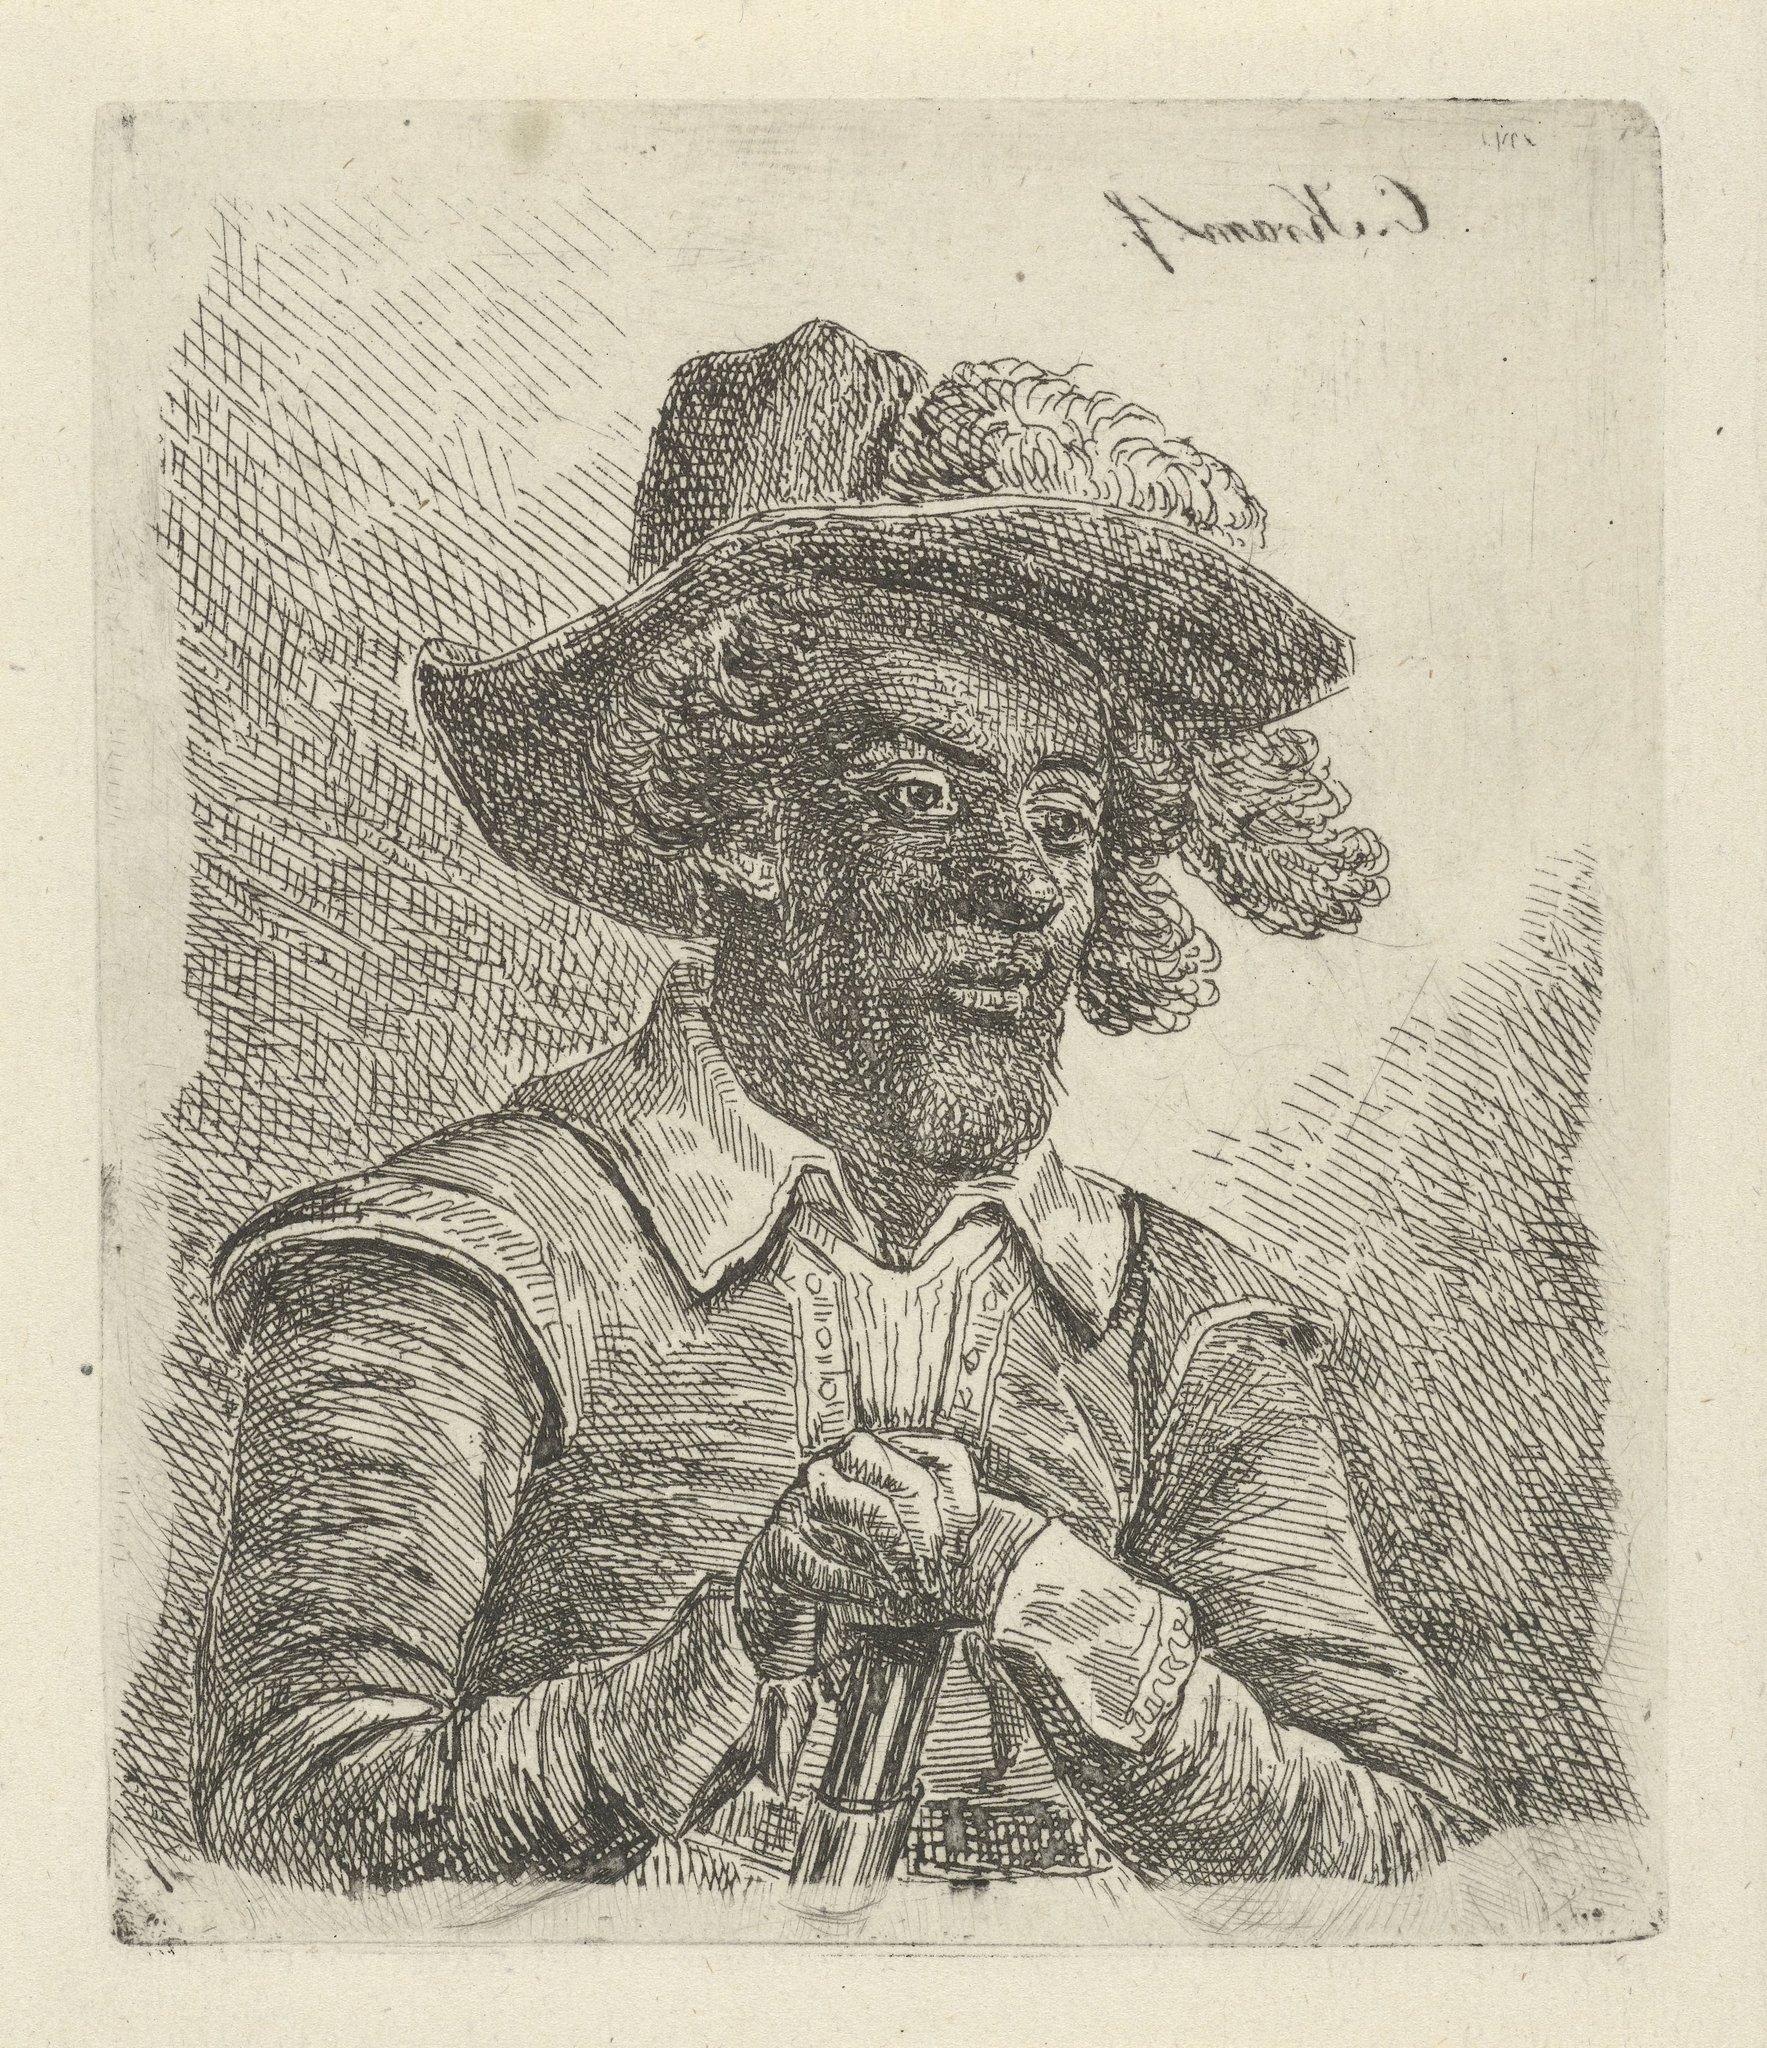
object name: print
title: Krijgsman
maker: christiaan kramm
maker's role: draughtsman, print maker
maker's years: 1797-1875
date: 1807-1875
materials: paper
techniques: etching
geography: utrecht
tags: the soldier; the soldier's life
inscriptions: collector's mark: Lugt 2228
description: Een krijgsman met een gevederde hoed op het hoofd. De man laat de handen rusten op de tromp van een geweer.